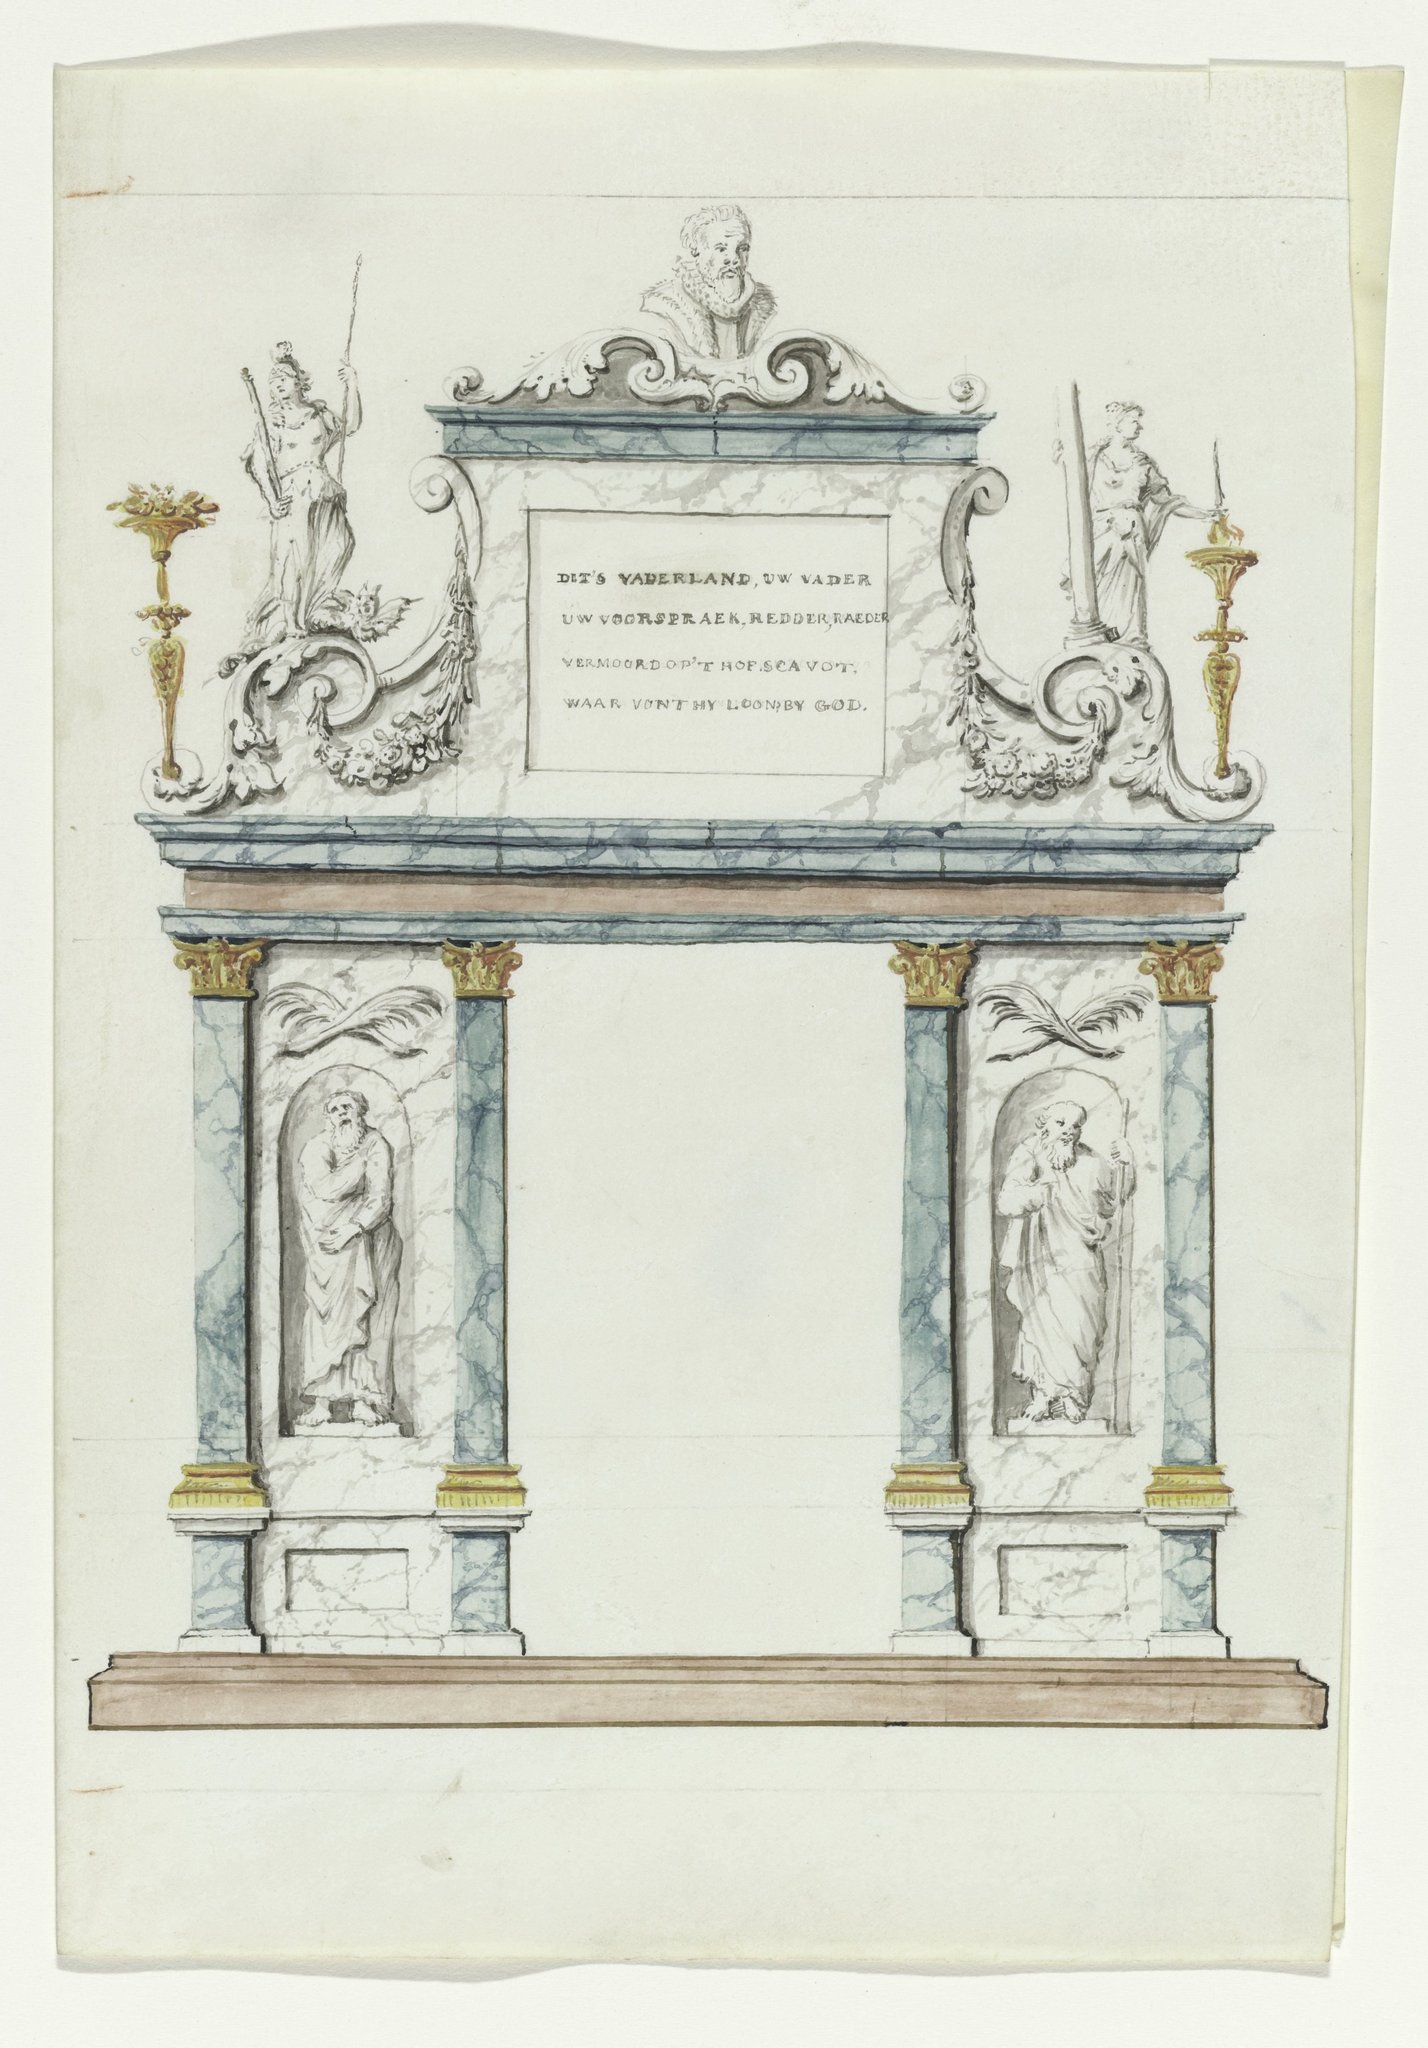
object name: drawing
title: Regtspleging van Oldenbarnevelt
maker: Anonymous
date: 1710-1720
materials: ink, parchment, watercolor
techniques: pen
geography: netherlands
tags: the hague, johan van oldenbarnevelt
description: Aquarel waarop erepoort met in het midden de tekst 'DIT'S VADERLAND, UW VADER UW VOORSPRAEKER, REDEER, RAEDER VERMOORD OP'T HOF.SCAVOT WAAR VONT HY LOON BY GOD'. Bijbehorend 3 losse handgeschreven teksten. Behorende bij serie aquarellen in boek.